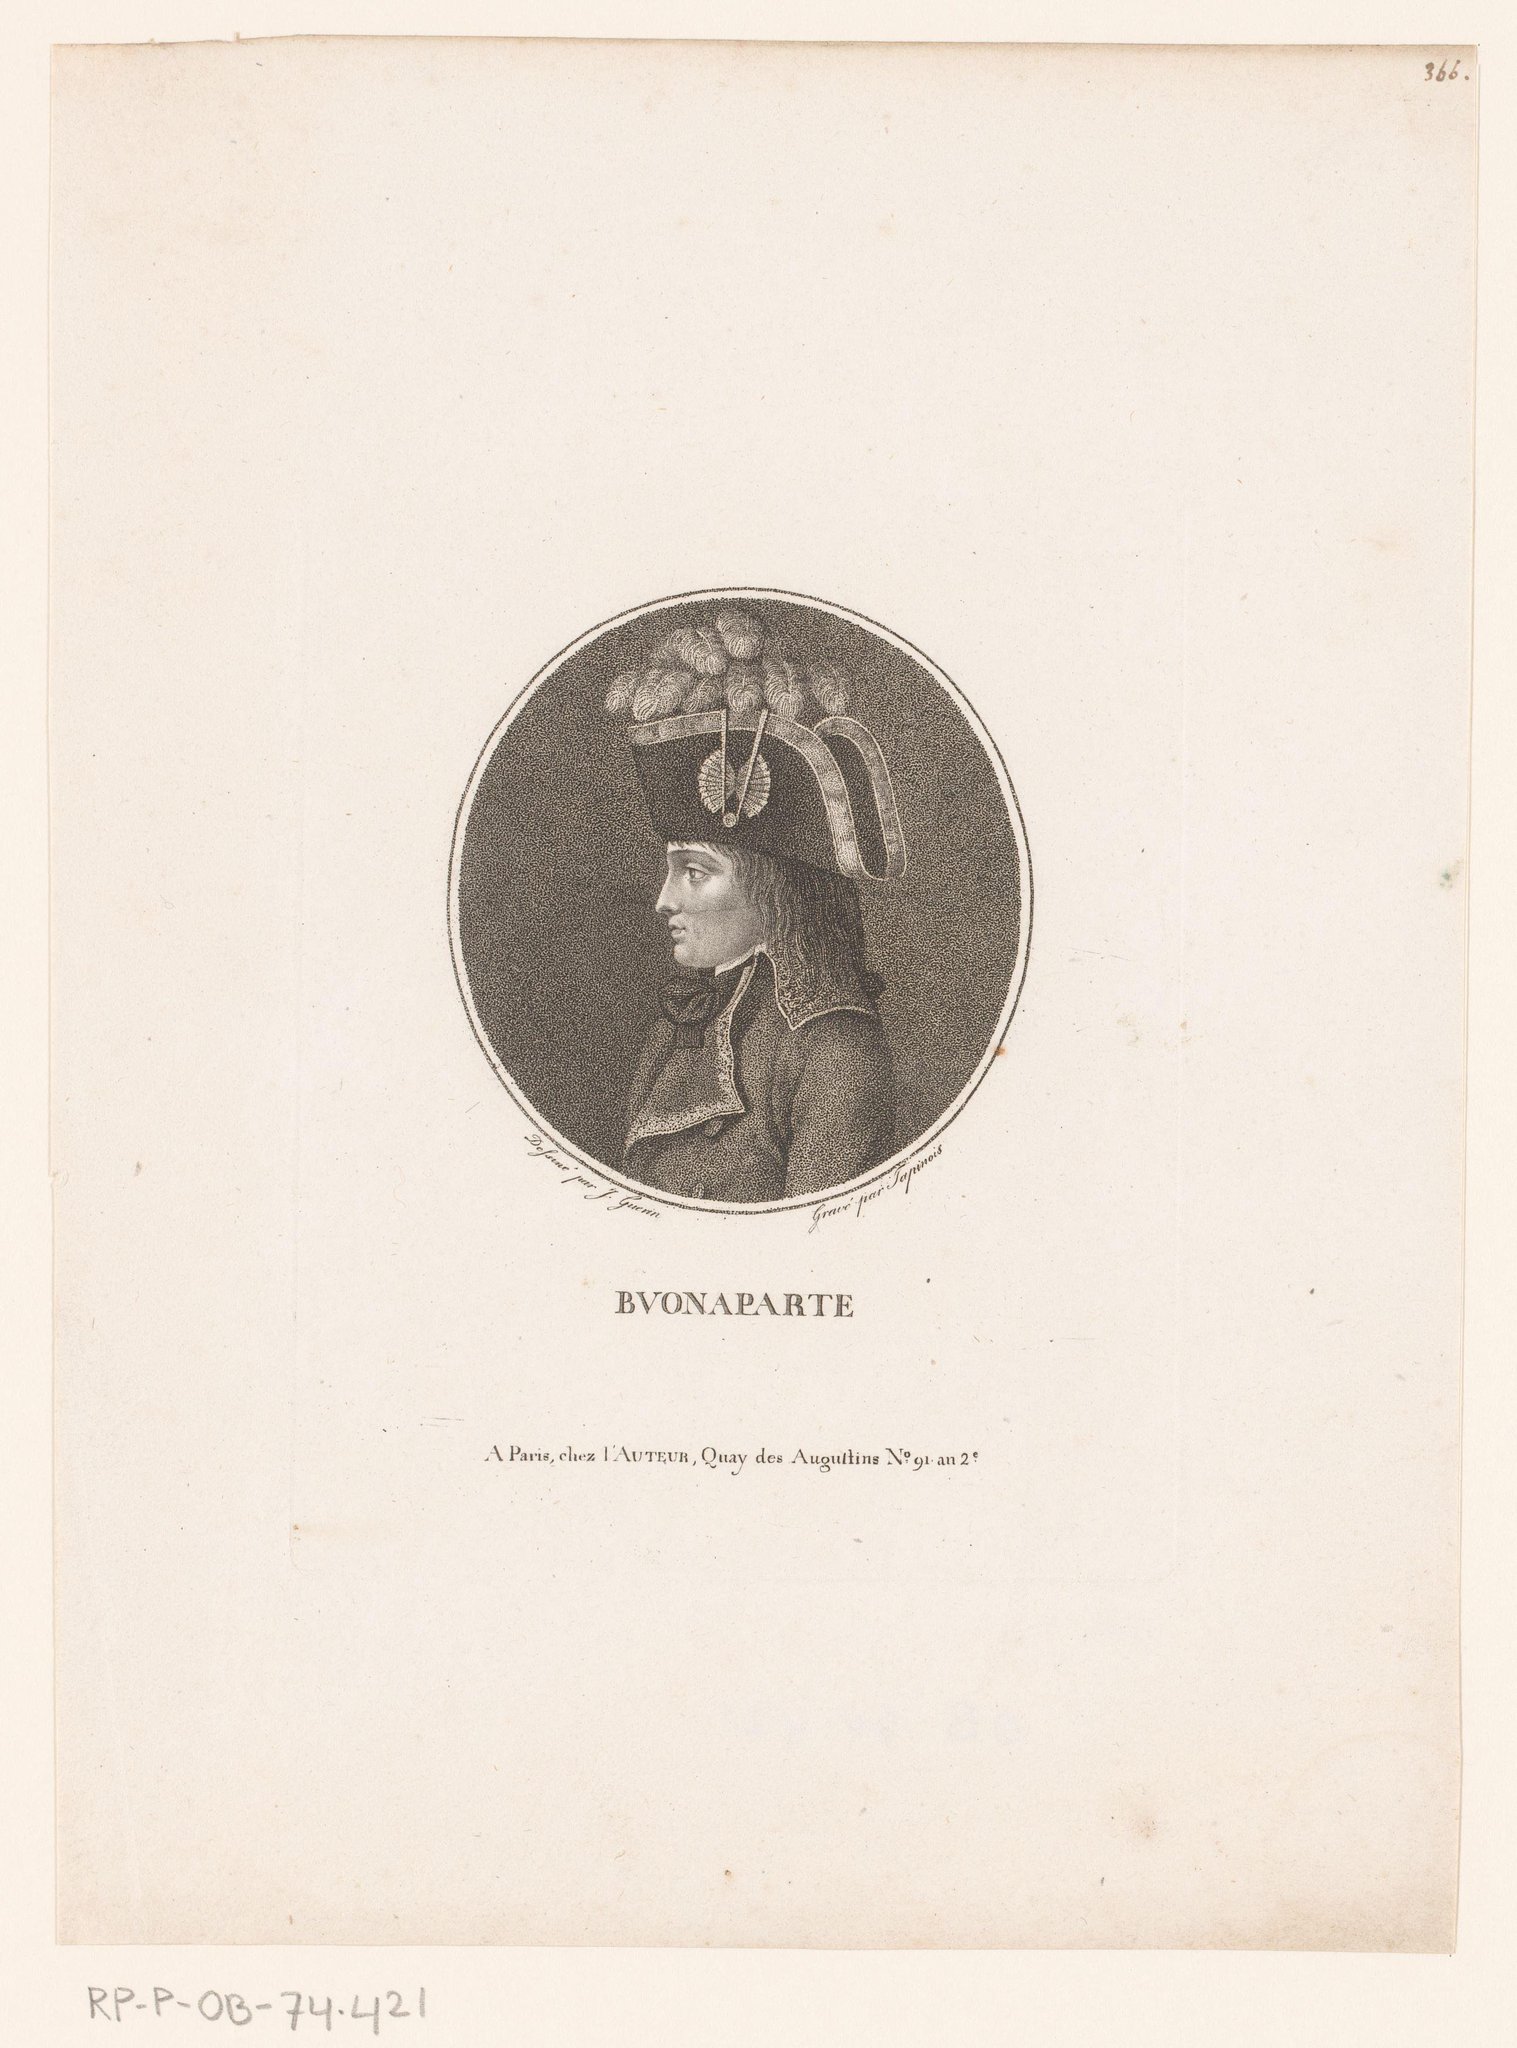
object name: print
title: Portret van Napoleon I Bonaparte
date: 1785-1815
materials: paper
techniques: stippling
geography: paris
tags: napoleon i (emperor of the french), historical persons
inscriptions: collector's mark: Lugt 2228